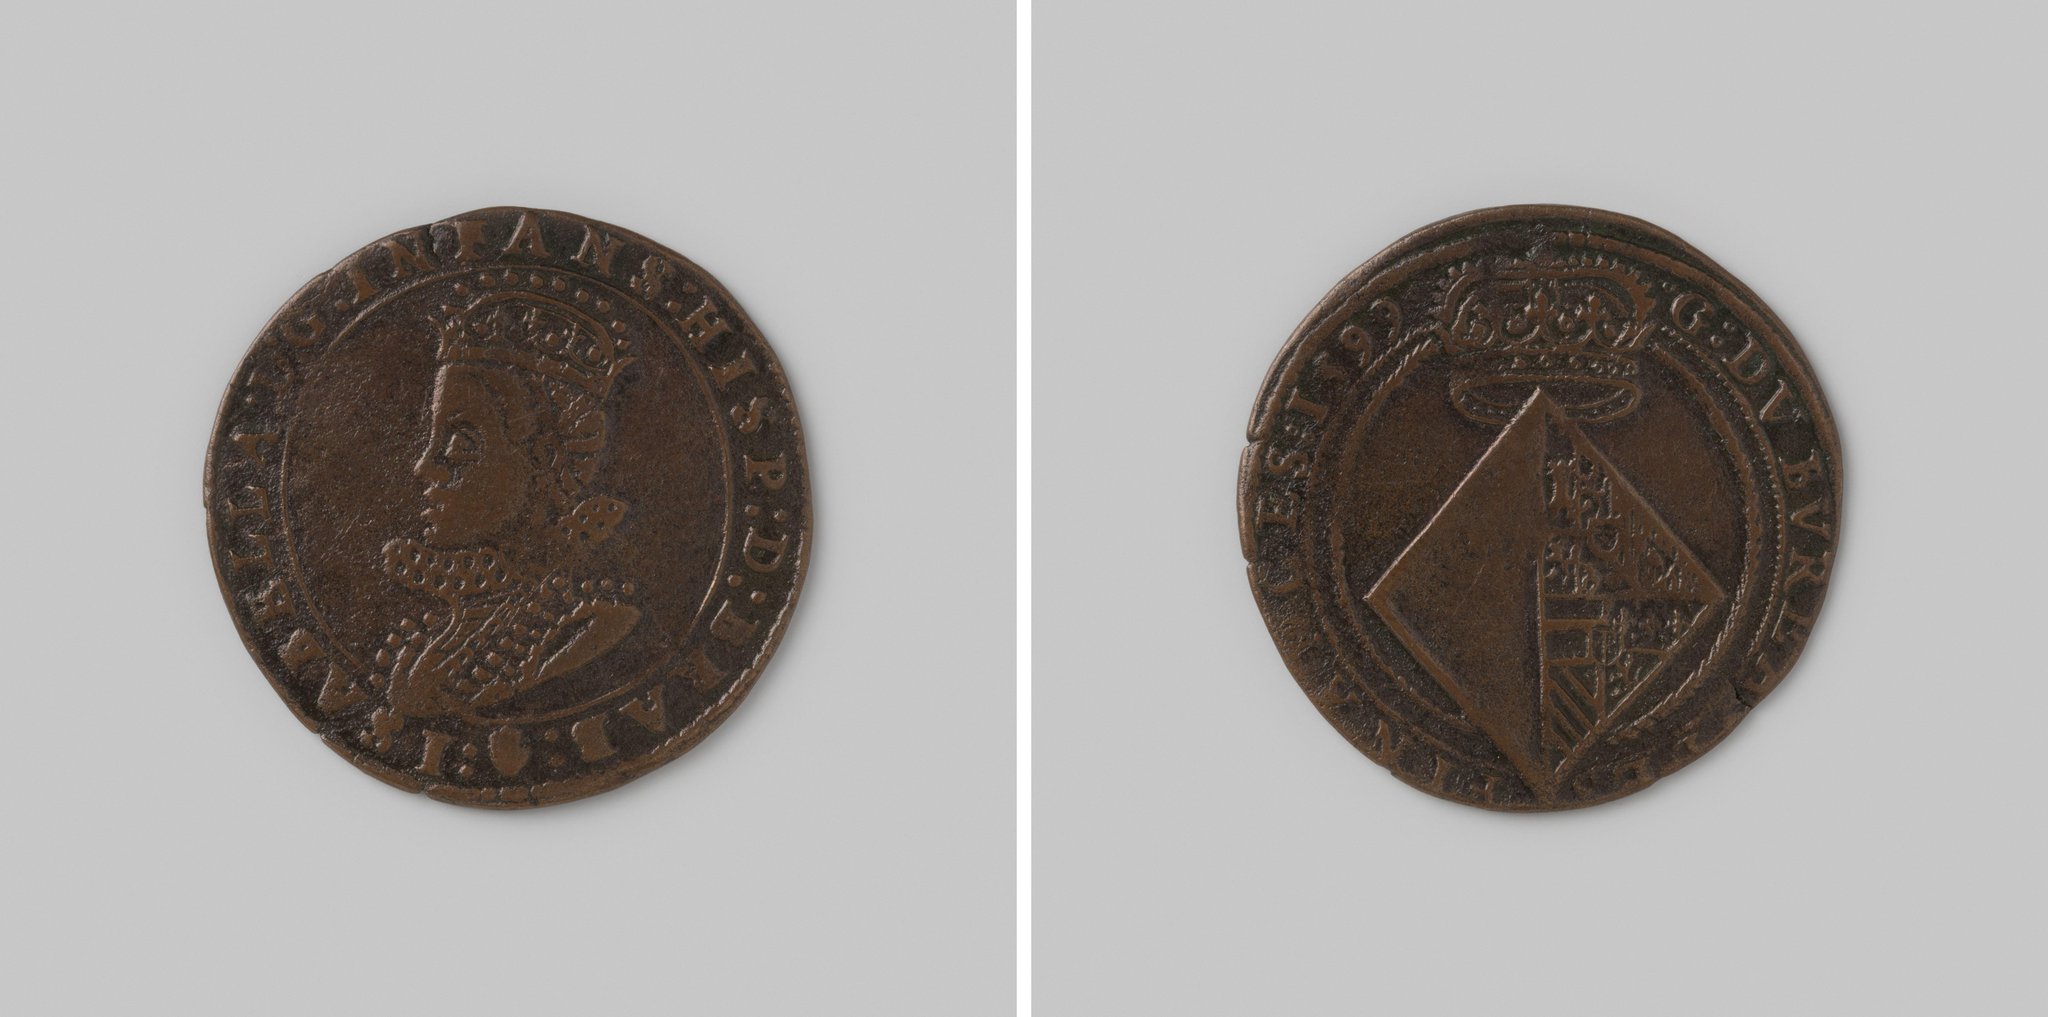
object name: history medal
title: Rekenpenning uit Antwerpen voor het Bureau van Financien op Isabella van Spanje als Hertogin van Brabant 1599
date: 1599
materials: copper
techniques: striking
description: Koperen penning, op de voorzijde het borstbeeld van Isabella naar links met omschrift, op de keerzijde een gekroond ruitvormig wapenschild, met omschrift.